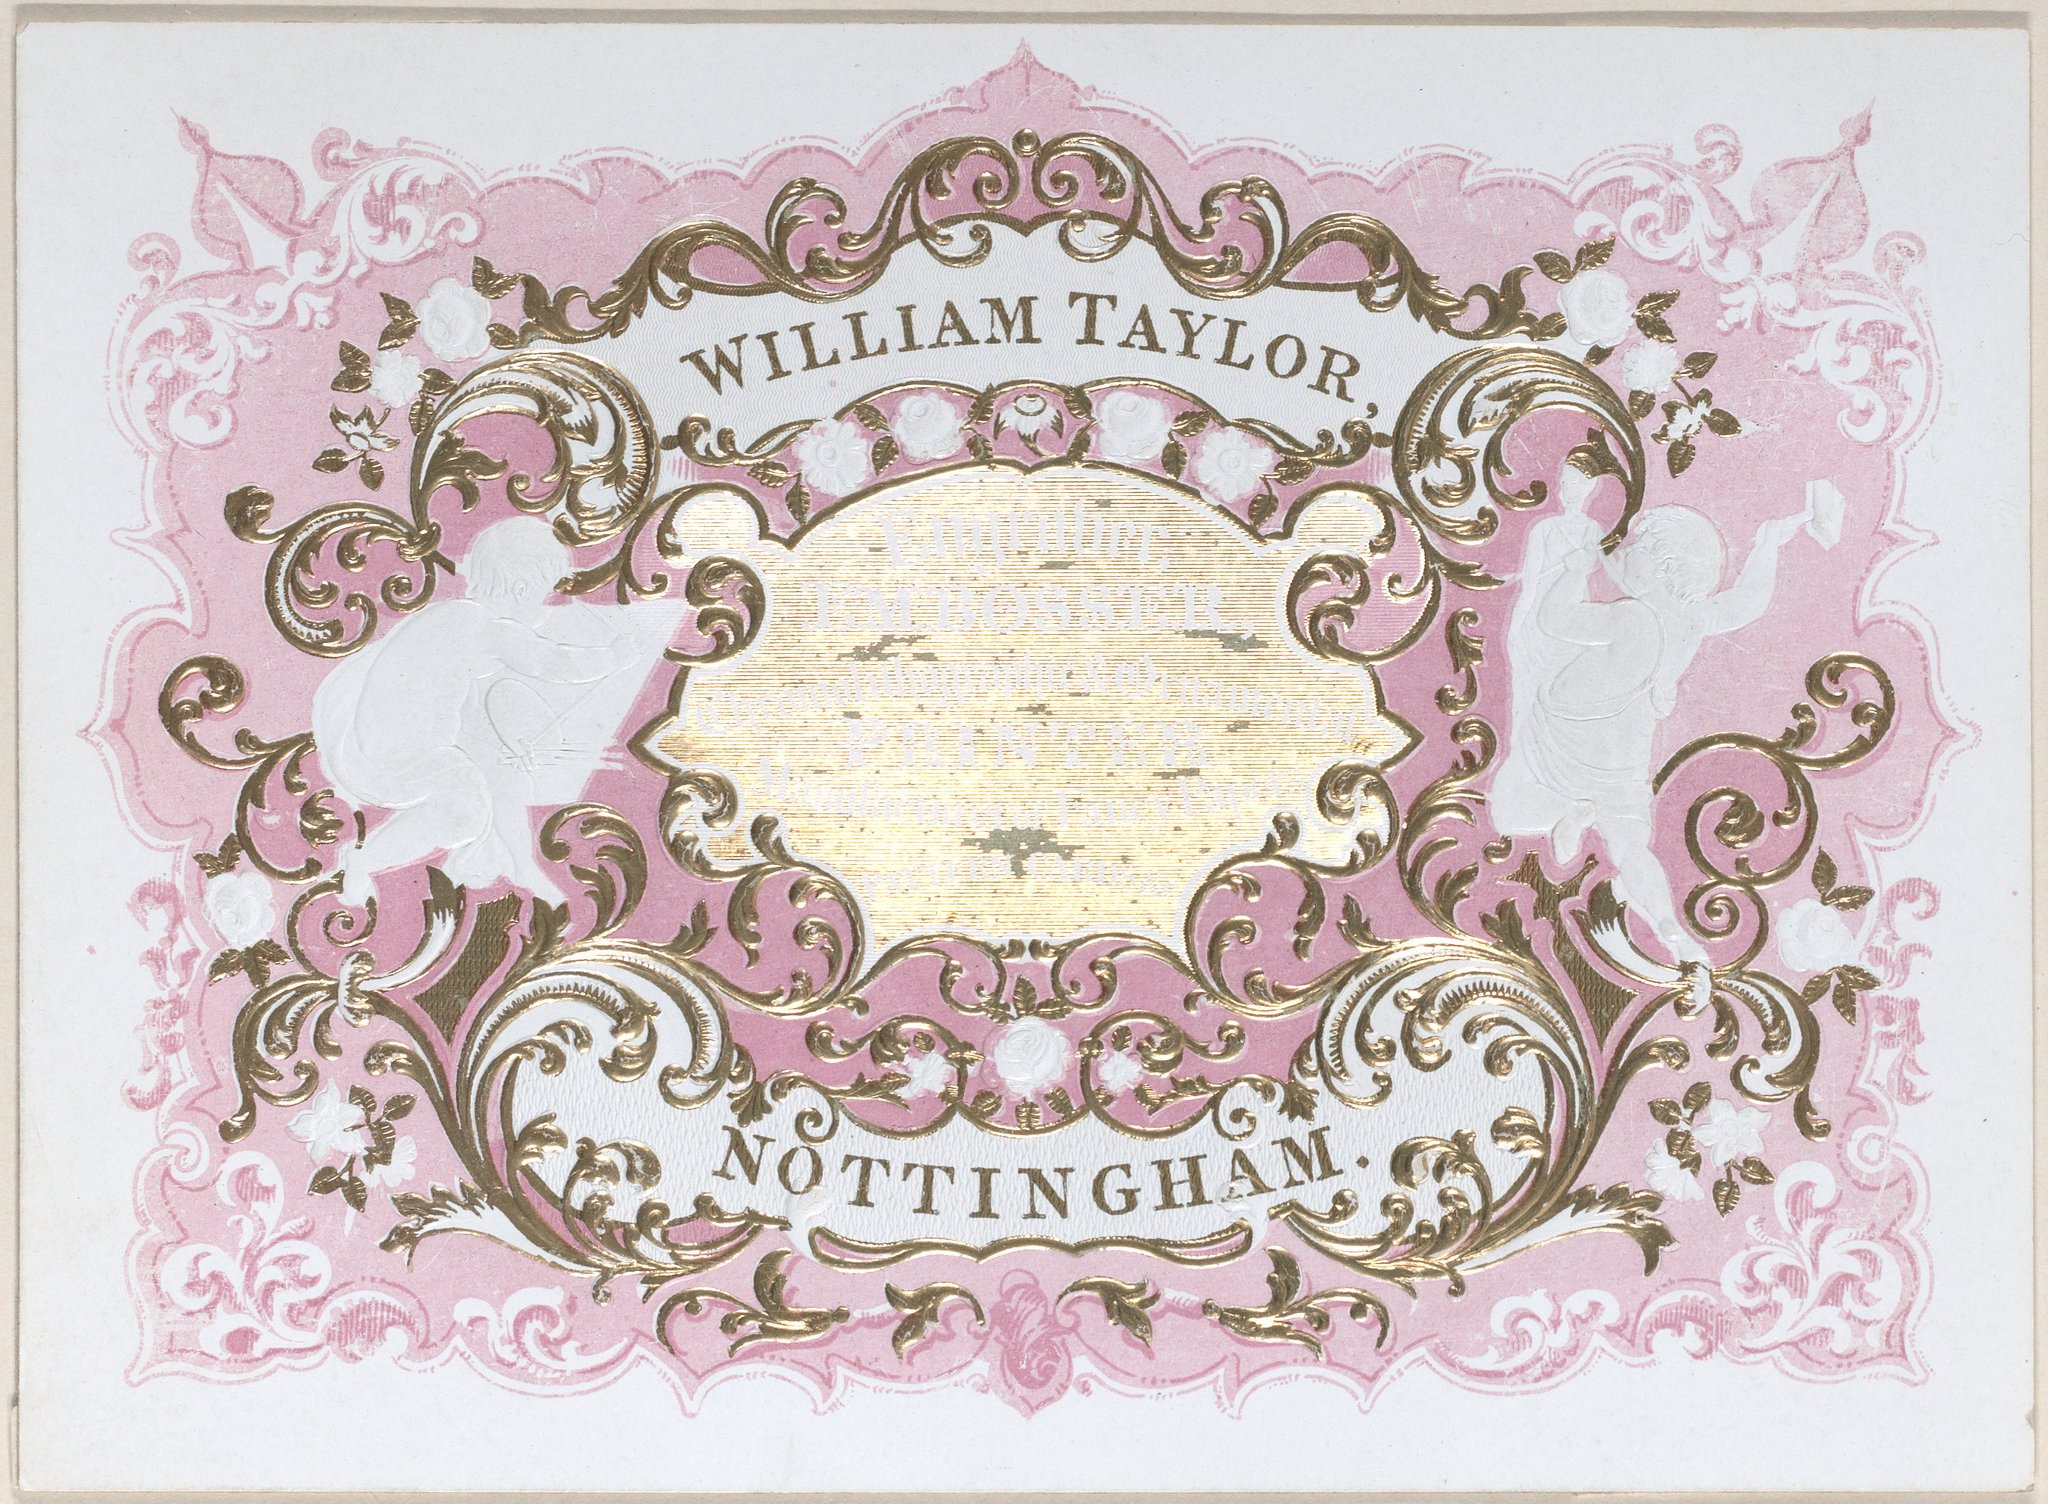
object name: trade card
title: Trade card for William Taylor, engraver, embosser and printer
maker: anonymous, british, 19th century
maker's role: artist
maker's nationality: british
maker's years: 1800-1900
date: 1801-1900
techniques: lithograph